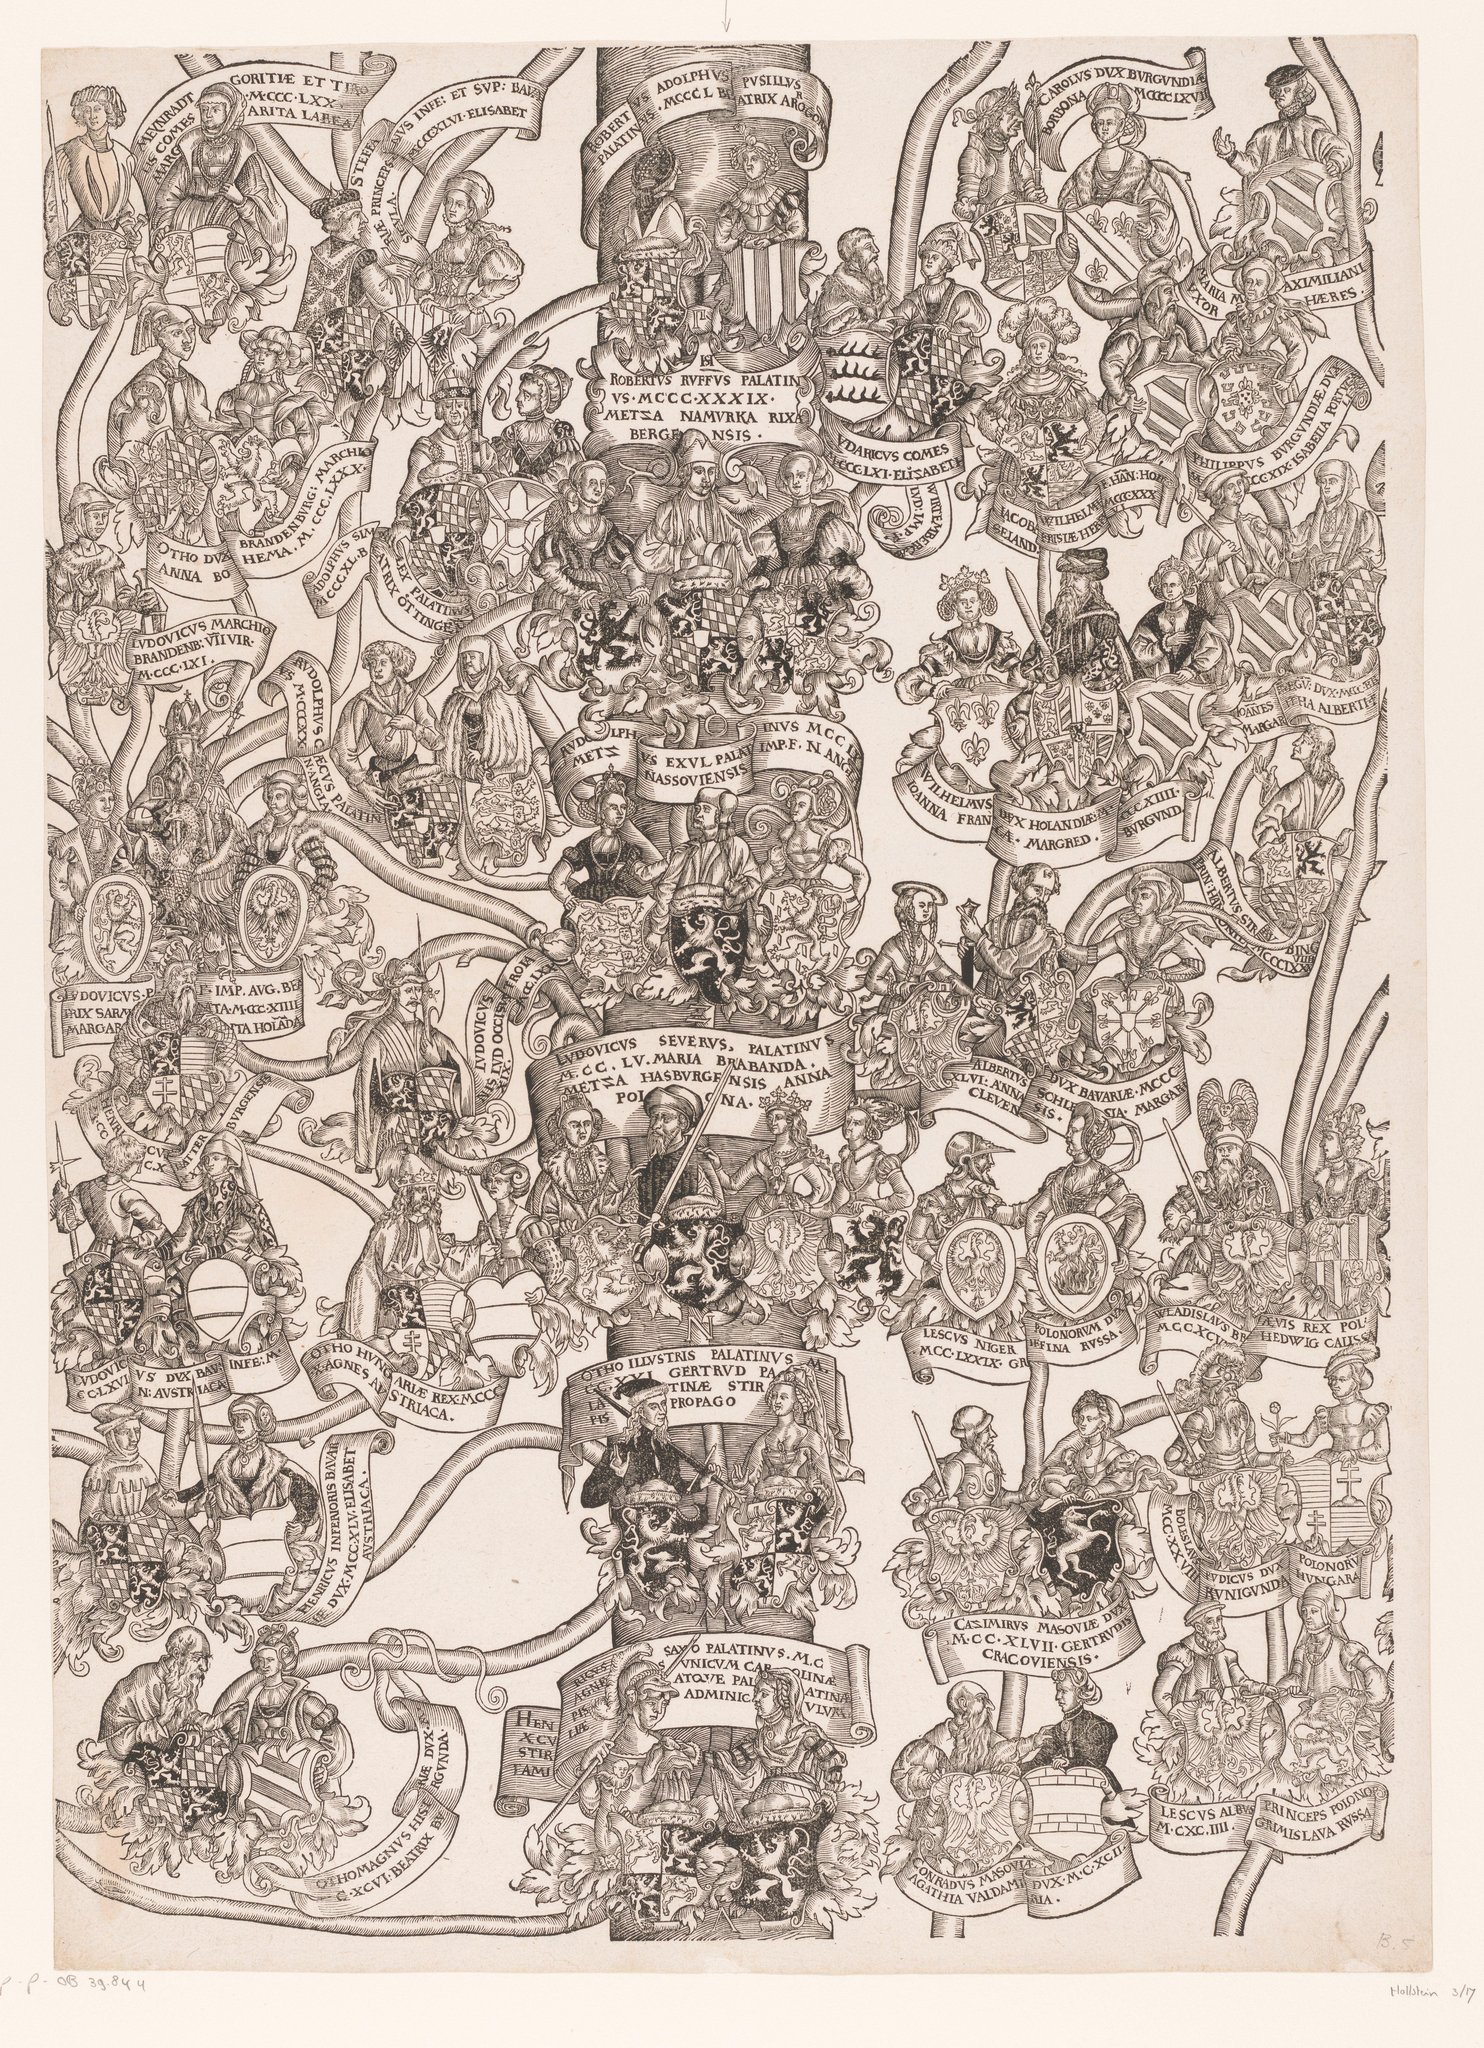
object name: print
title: Stamboom van Frederik en Ottheinrich van Palts-Neuburg (plaat 17)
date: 1535-1594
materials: paper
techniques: letterpress printing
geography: basel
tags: earl, family lineage, pedigree, genealogical tree or table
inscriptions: collector's mark: Lugt 240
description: Blad 17 van een stamboom bestaande uit 21 bladen, gedrukt van 42 blokken.